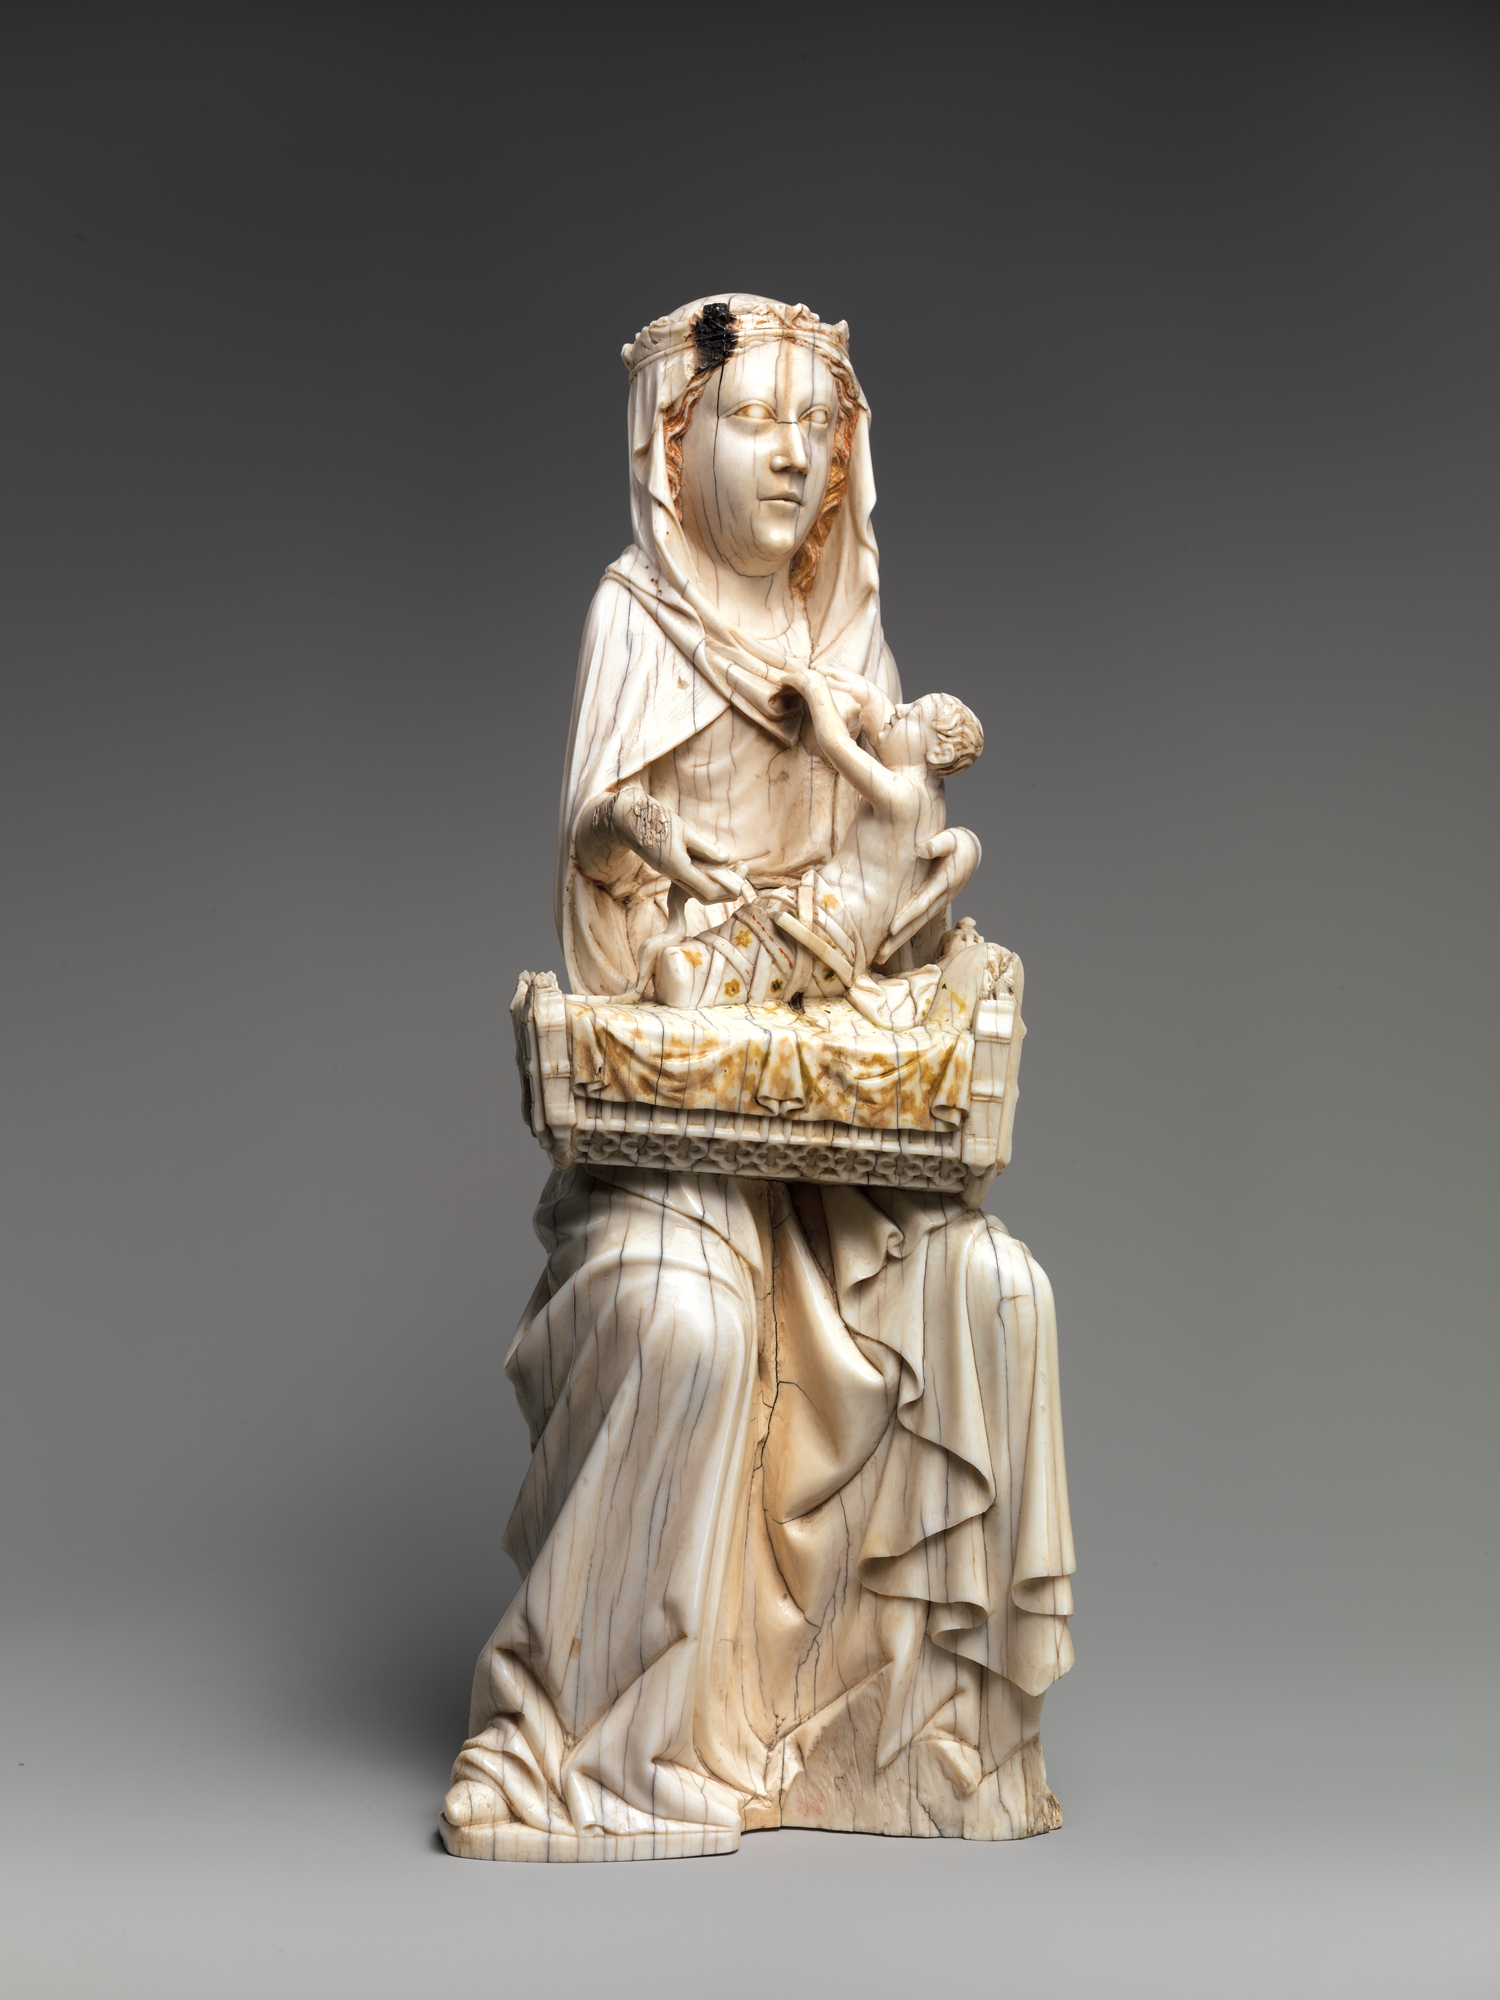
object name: statuette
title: Virgin and Child with Cradle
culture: german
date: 1350-1400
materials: ivory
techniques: polychromy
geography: germany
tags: madonna and child,cradles